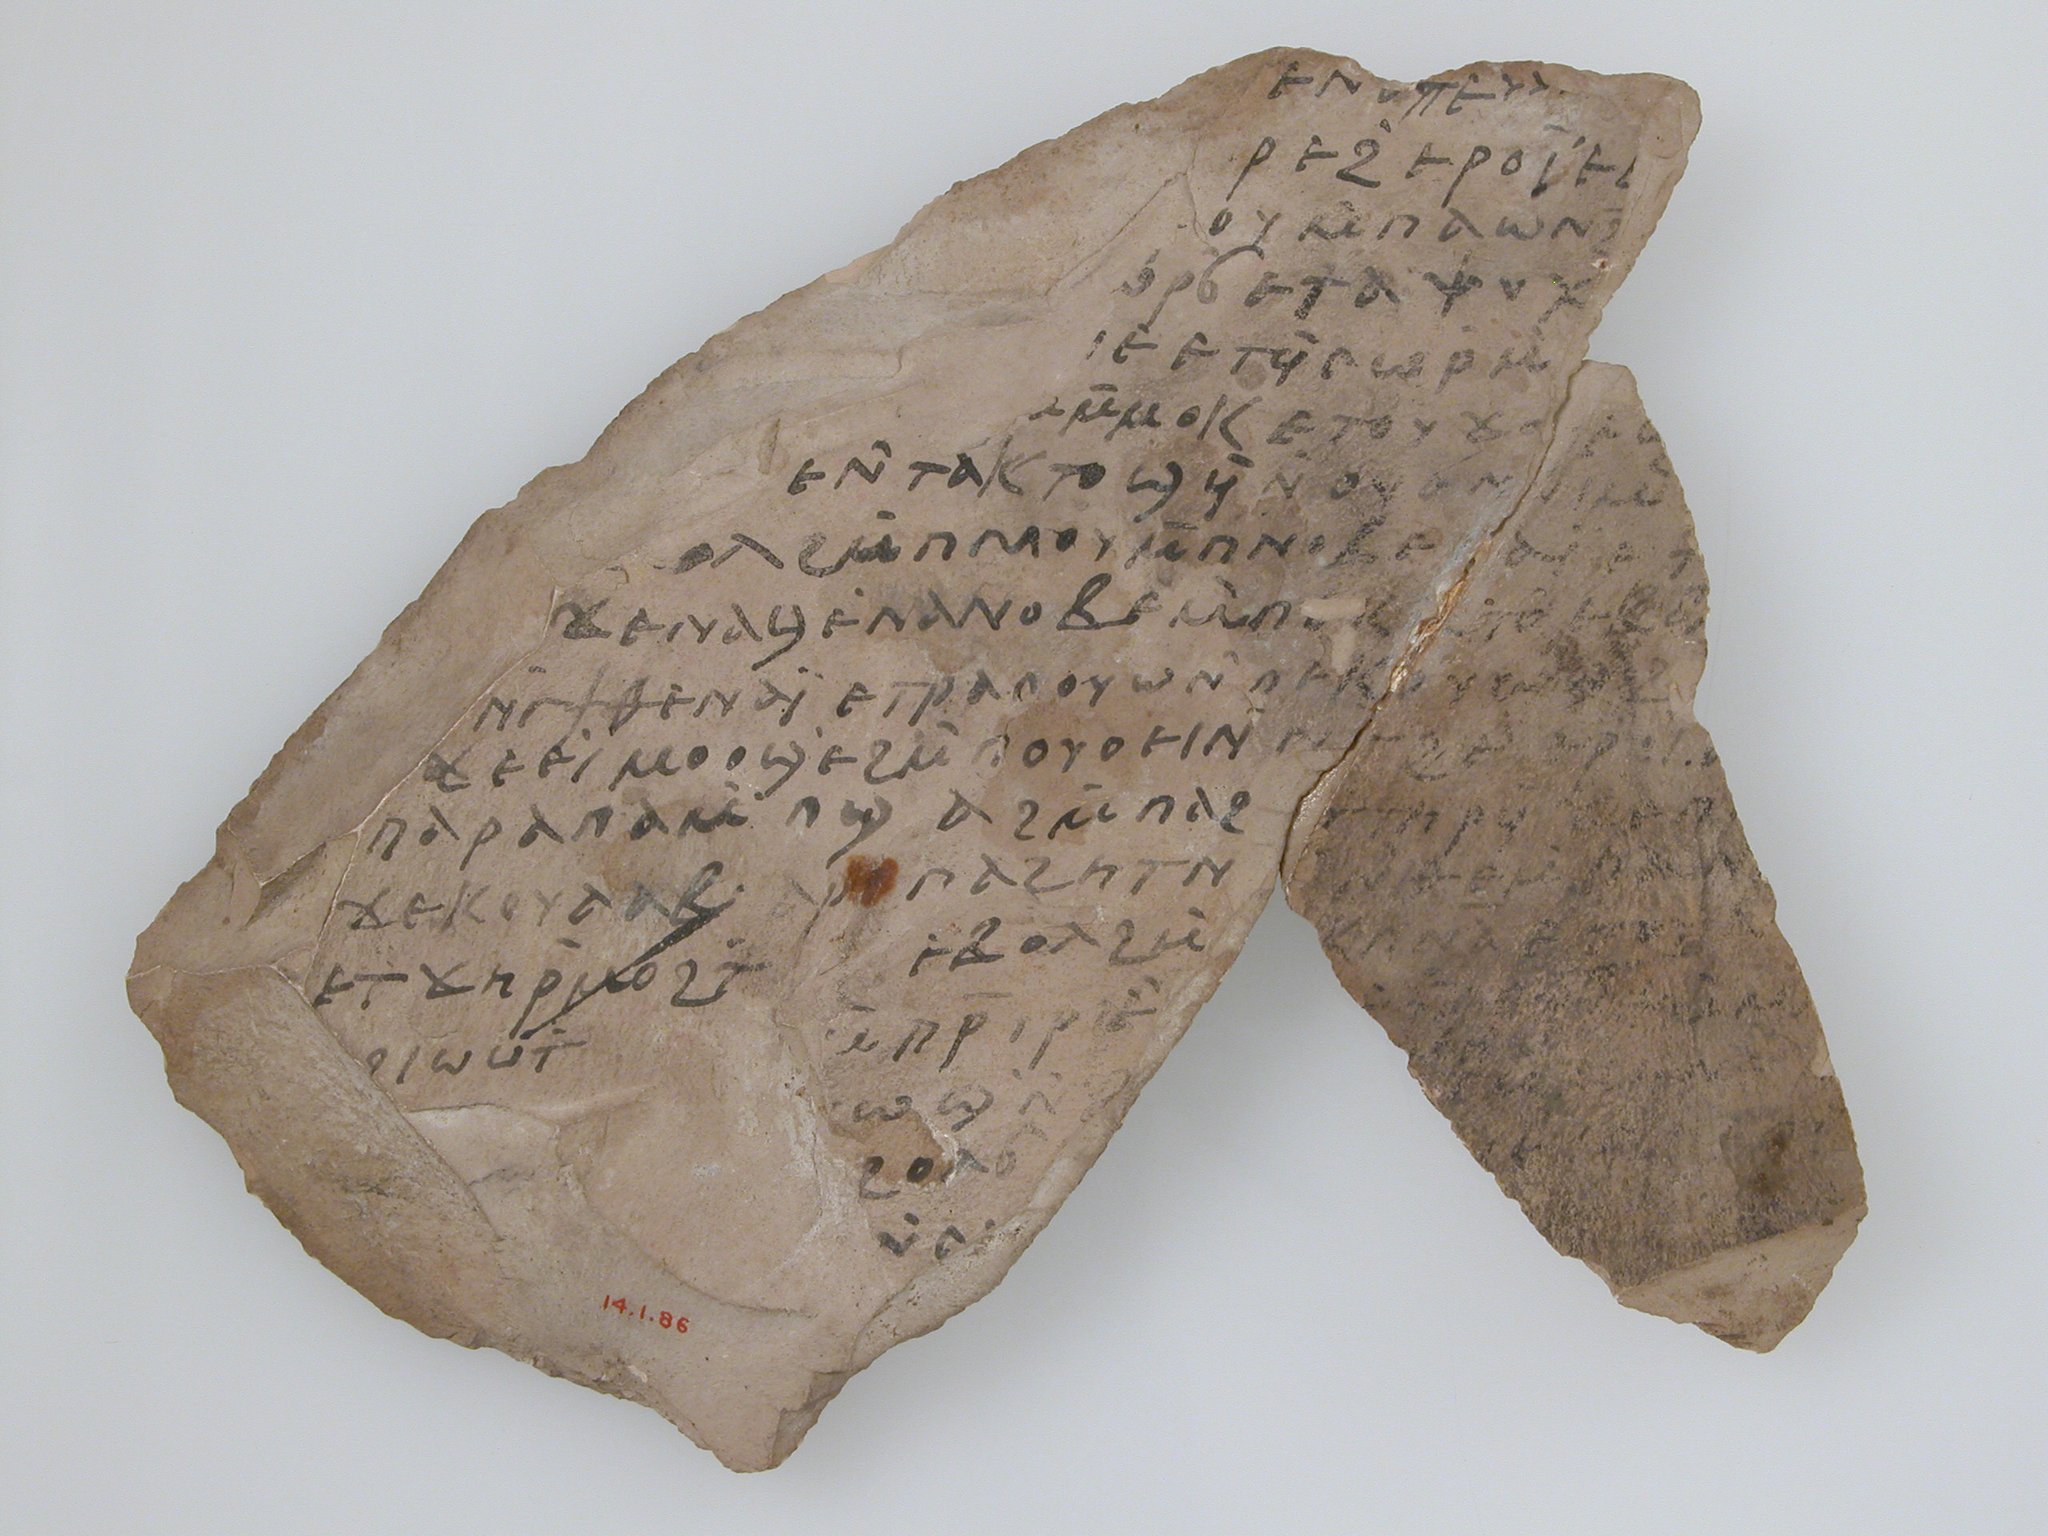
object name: ostrakon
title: Ostrakon Fragments of a Liturgical Text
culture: coptic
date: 600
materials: ink, limestone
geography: egypt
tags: coptic